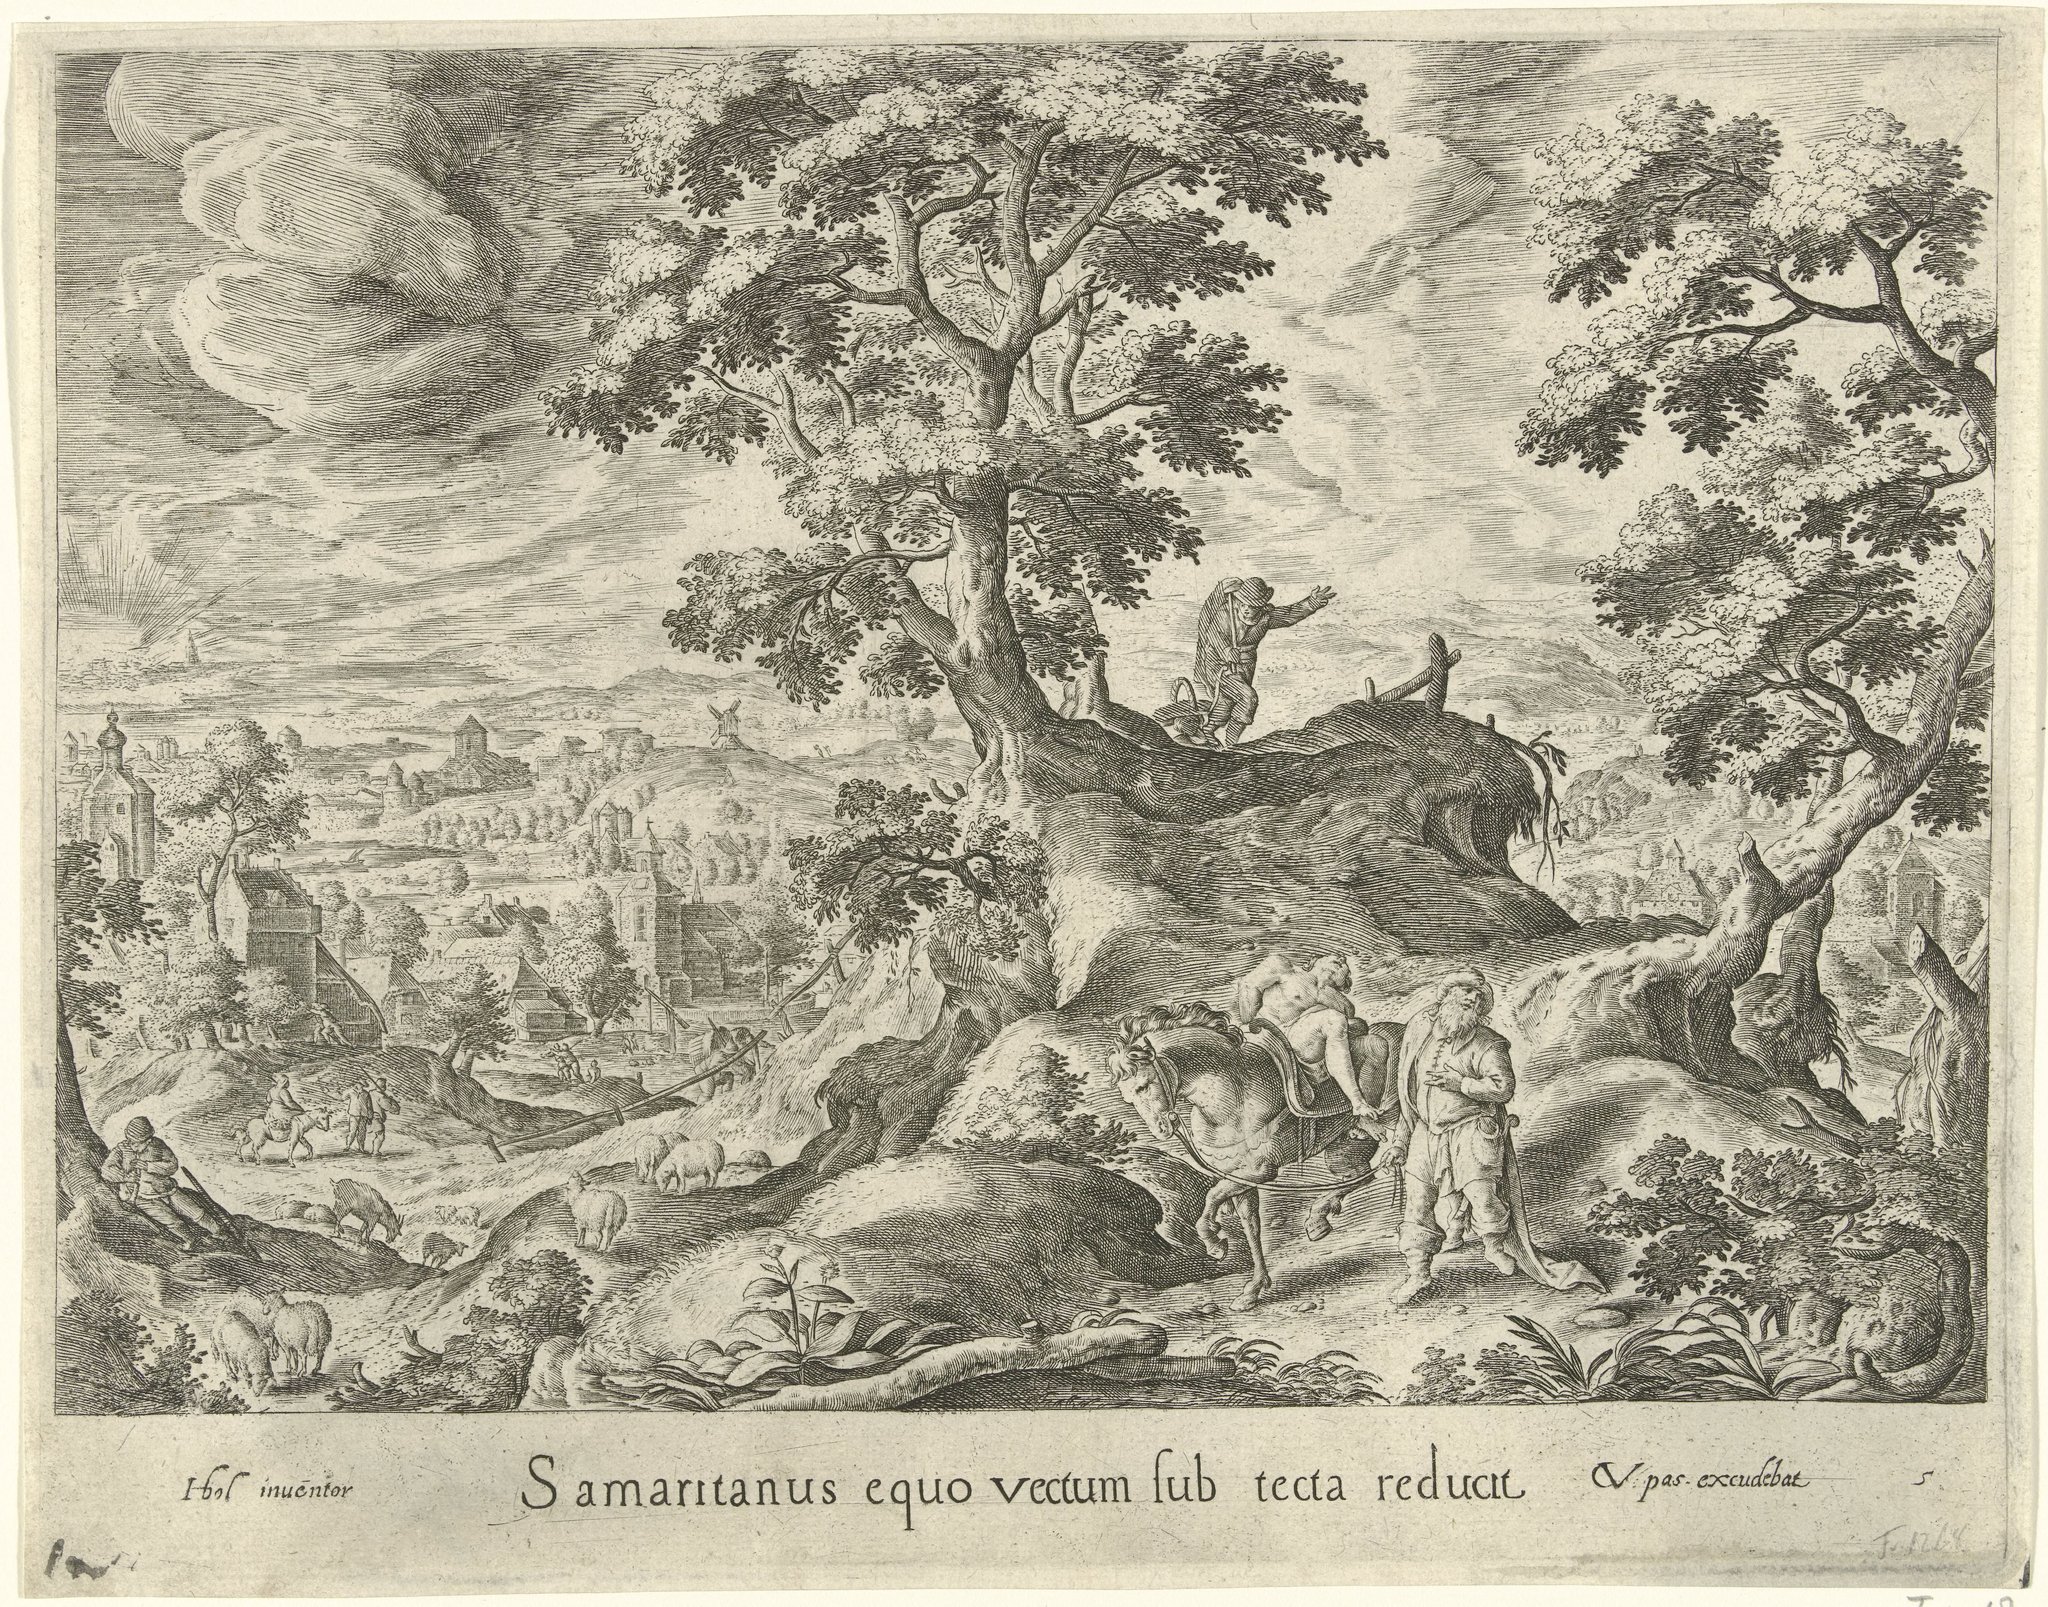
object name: print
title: Reis van de barmhartige Samaritaan en de gewonde reiziger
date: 1588-1589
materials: paper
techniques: engraving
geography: aachen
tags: the samaritan sets the wounded traveller on his mount (ass or horse), and brings him to an inn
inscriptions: collector's mark: Lugt 2228, collector's mark: Lugt 1337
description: De barmhartige Samaritaan vervoert de gewonde reiziger op zijn paard. In de marge een regel in het Latijn.